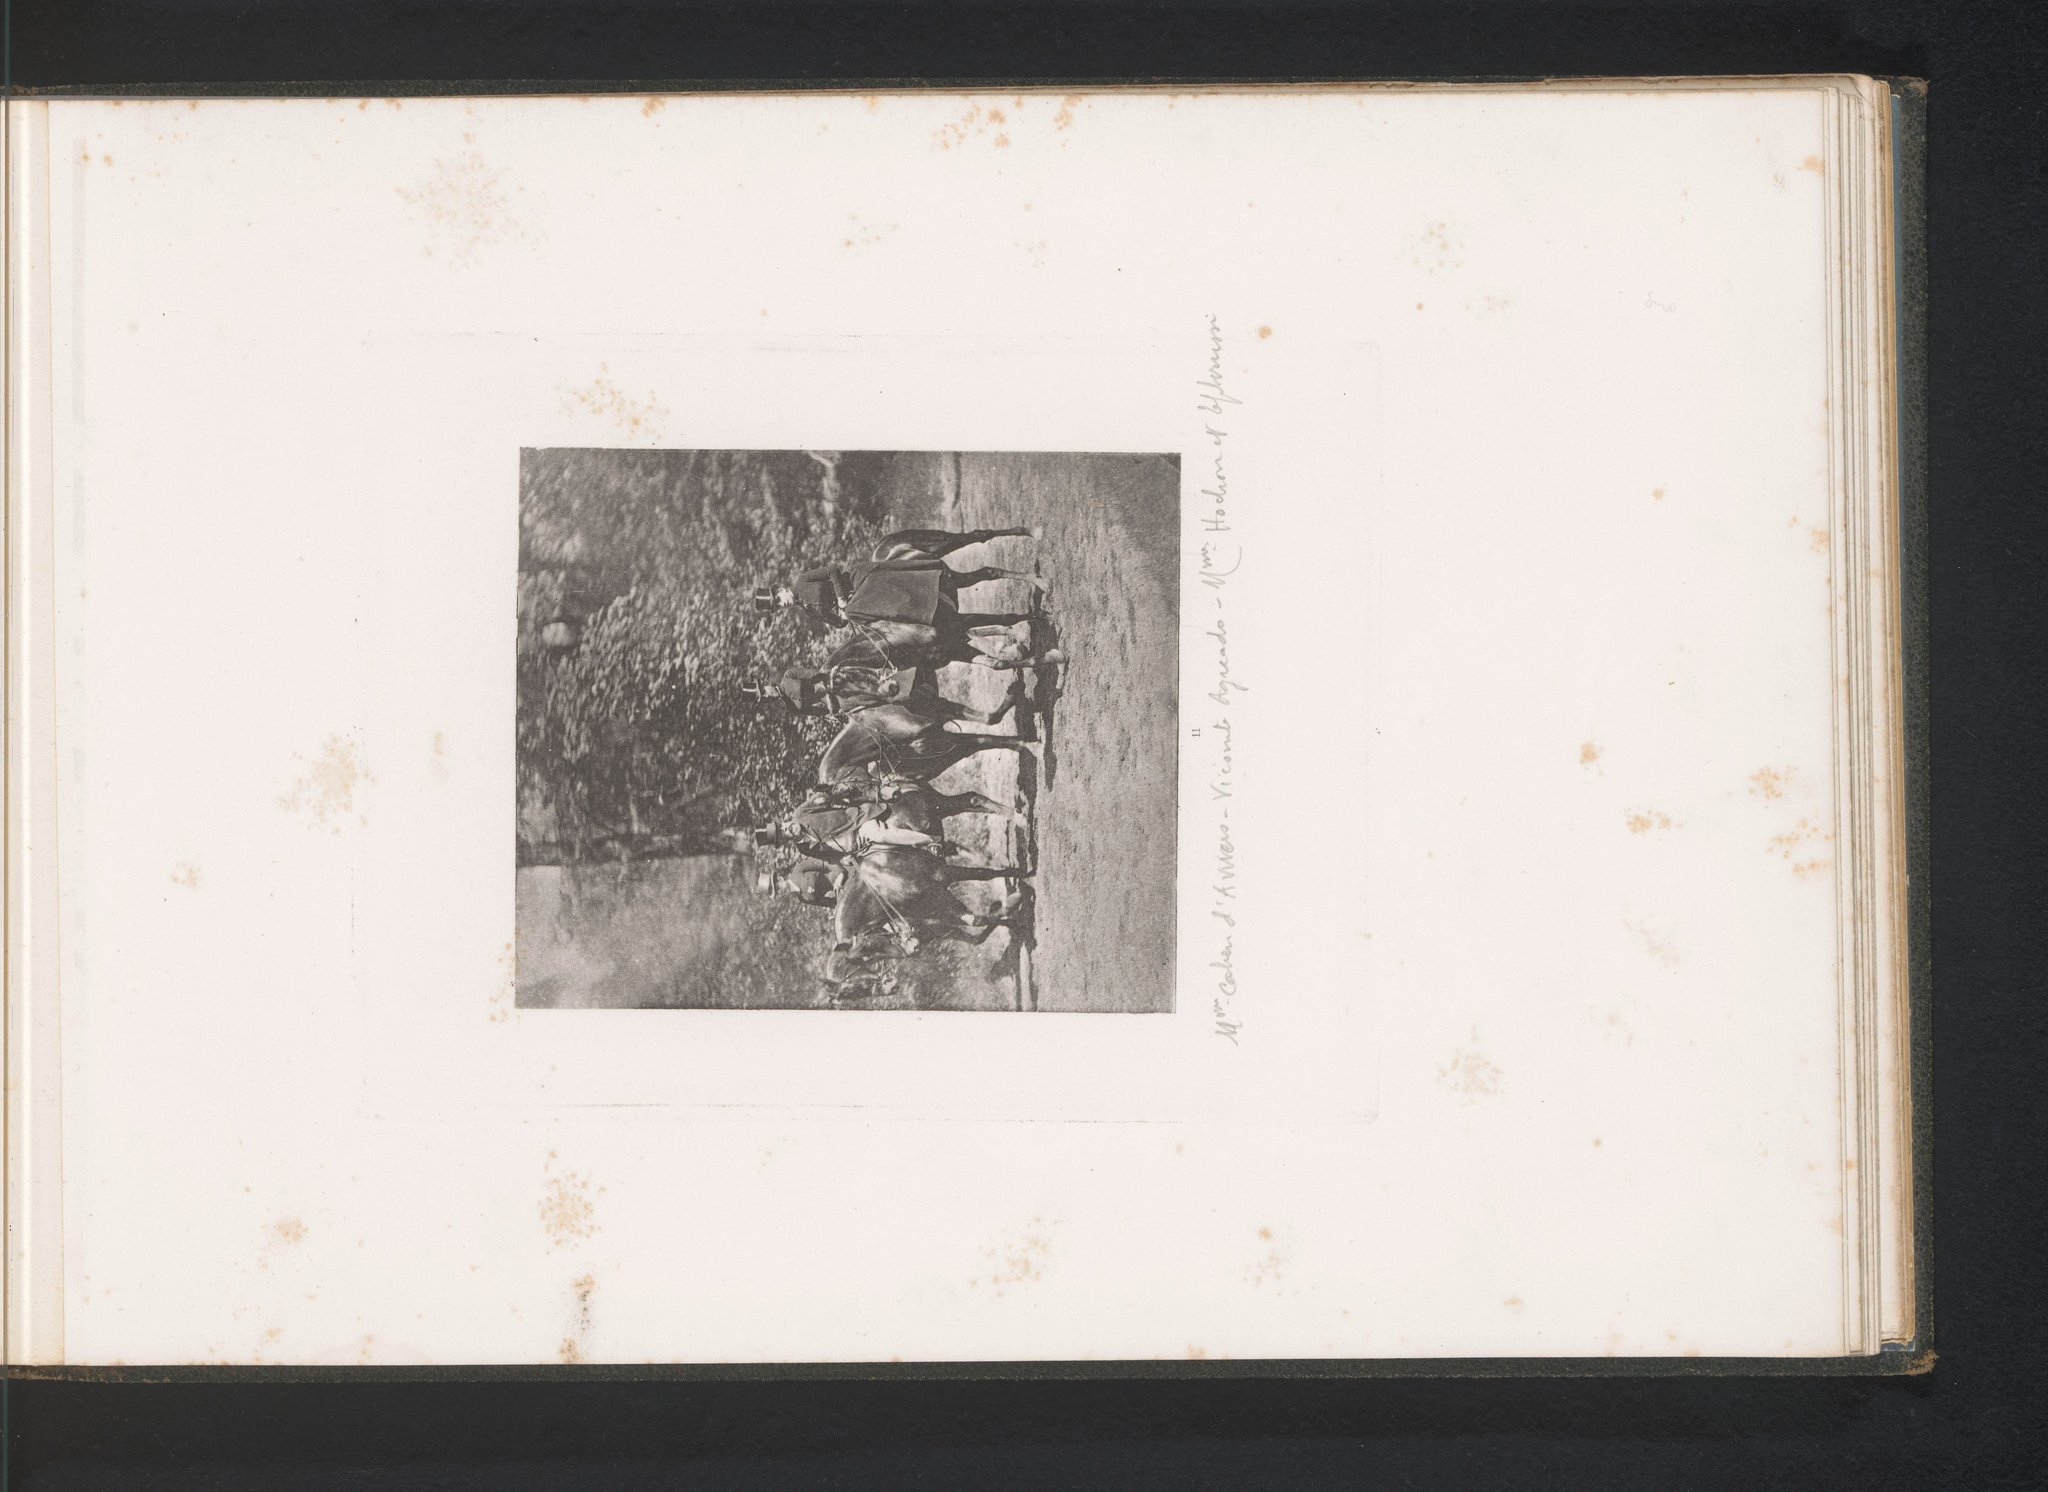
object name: photomechanical print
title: Vier ruiters te paard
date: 1874-1884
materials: paper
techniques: photoaquatint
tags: riding a horse, ass, or mule; rider, horseman, head-gear: top hat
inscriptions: inscription: ‘Mme Cahen d'Anvers - Vicomte Aguado - Mme. Hochon M Ephrussi’, number: ‘11’